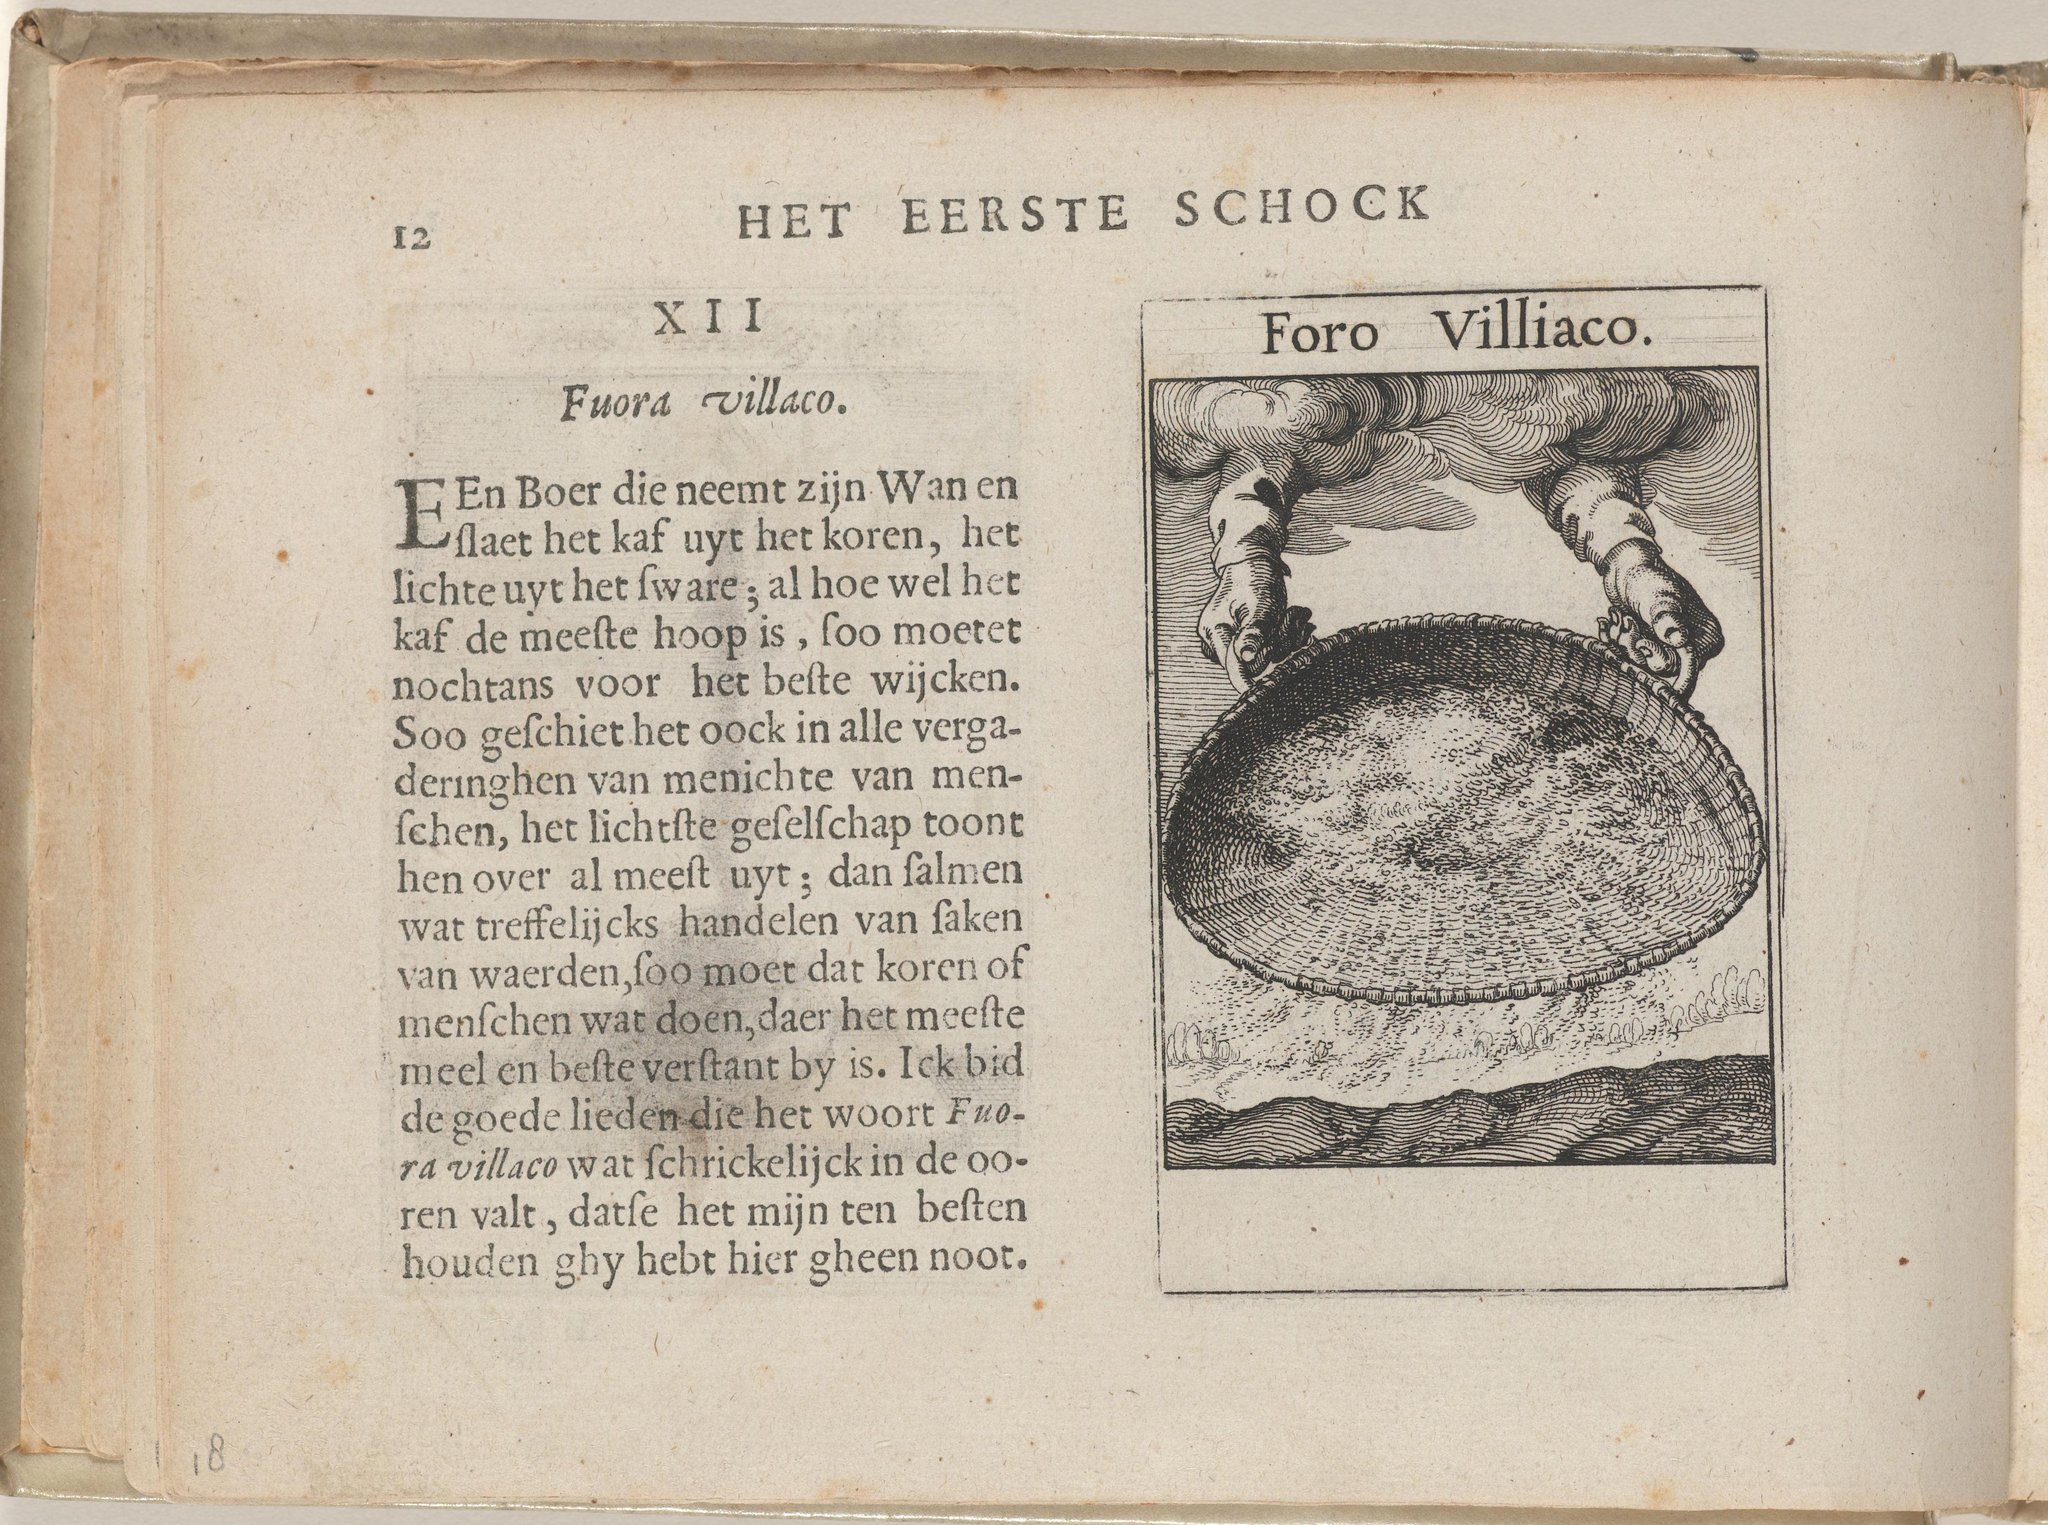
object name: album leaf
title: XII Foro Villiaco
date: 1614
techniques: engraving, printing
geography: the hague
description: XII Foro Villiaco. Eerste schok. Onderdeel van 'Sinnepoppen', R. Visscher, 1614.